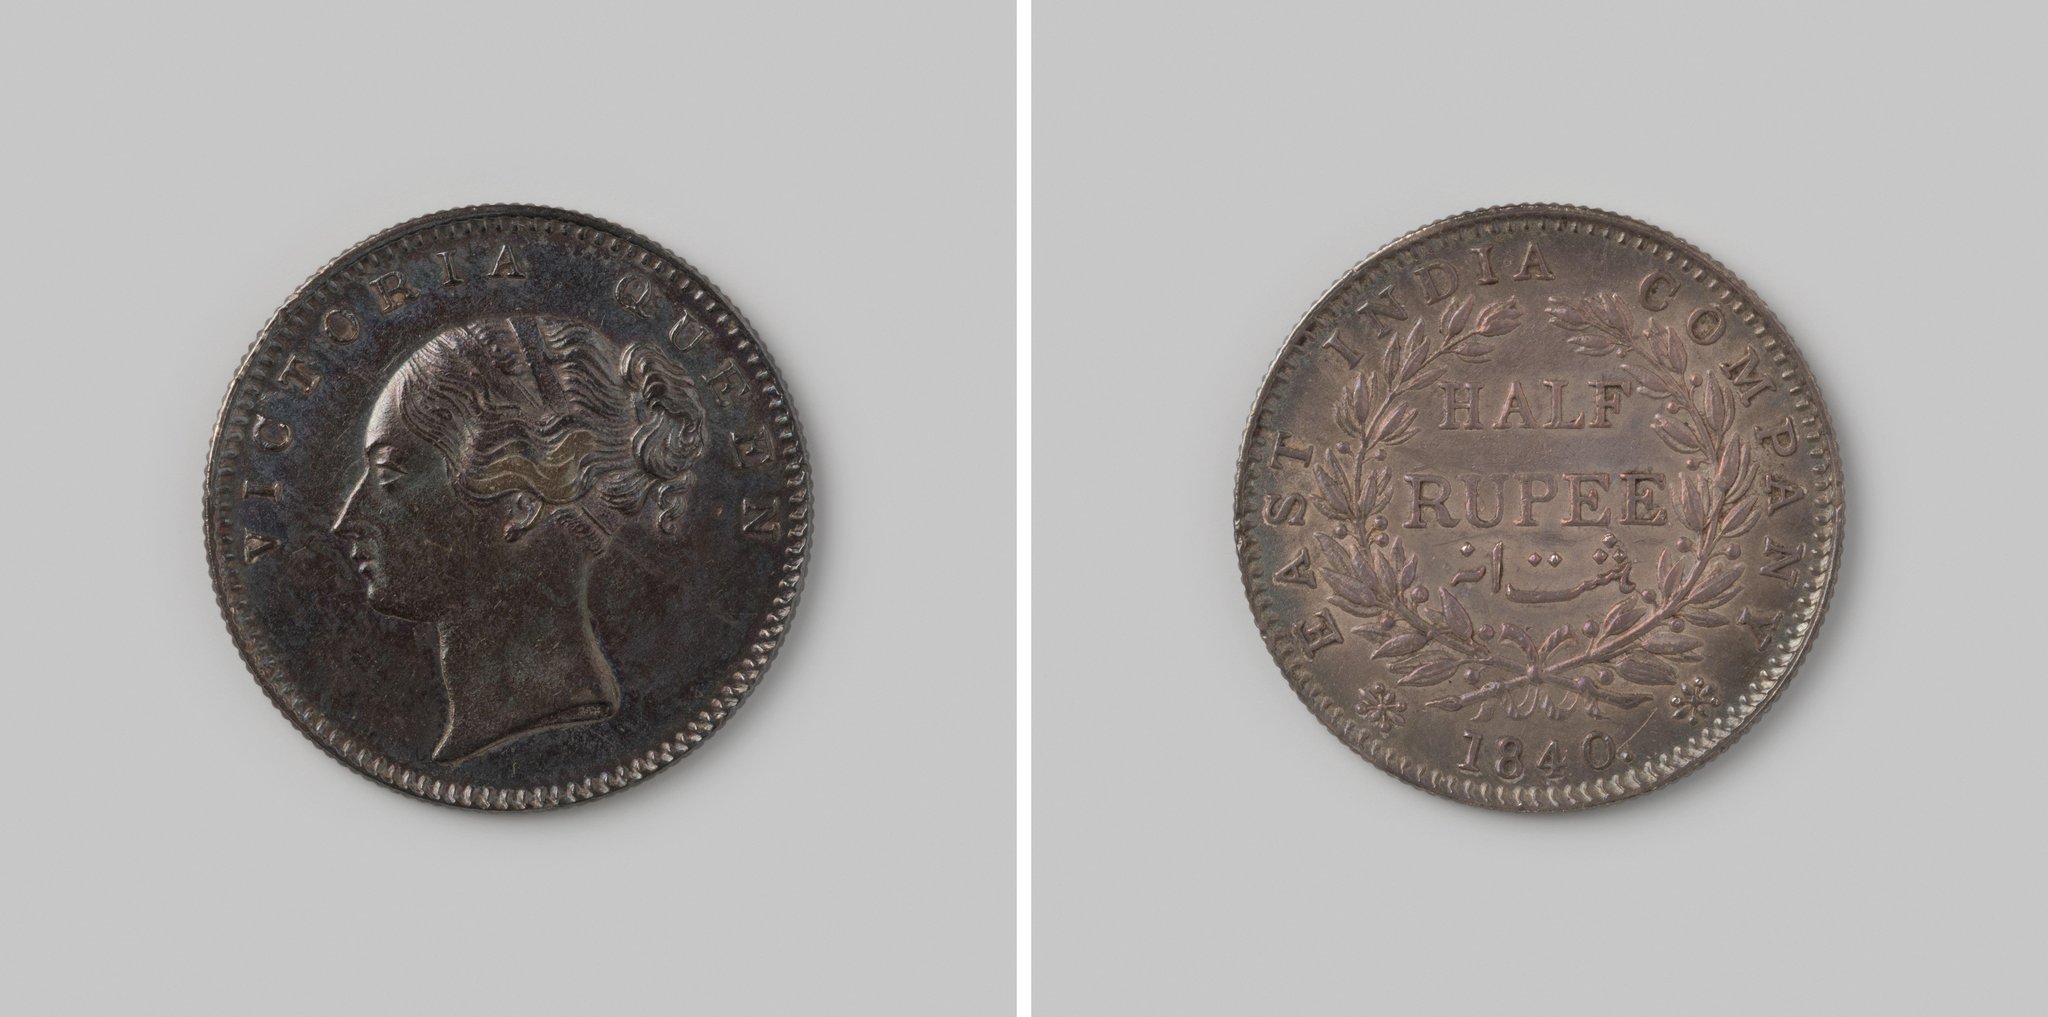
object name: coin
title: India, Engelse Oostindische Compagnie (EIC), op naam van koningin Victoria, ½ roepie, 1840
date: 1840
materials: silver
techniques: striking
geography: mumbai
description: Zilveren munt. Voorzijde: hoofd van koningin Victoria naar links. Omschrift doorlopend. Keerzijde: tussen twee samengebonden takken in twee regels waarde-aanduiding: half rupee, waaronder in Arabische lettertekens in een regel waarde-aanduiding. Onderaan jaartal. Kartelrand.